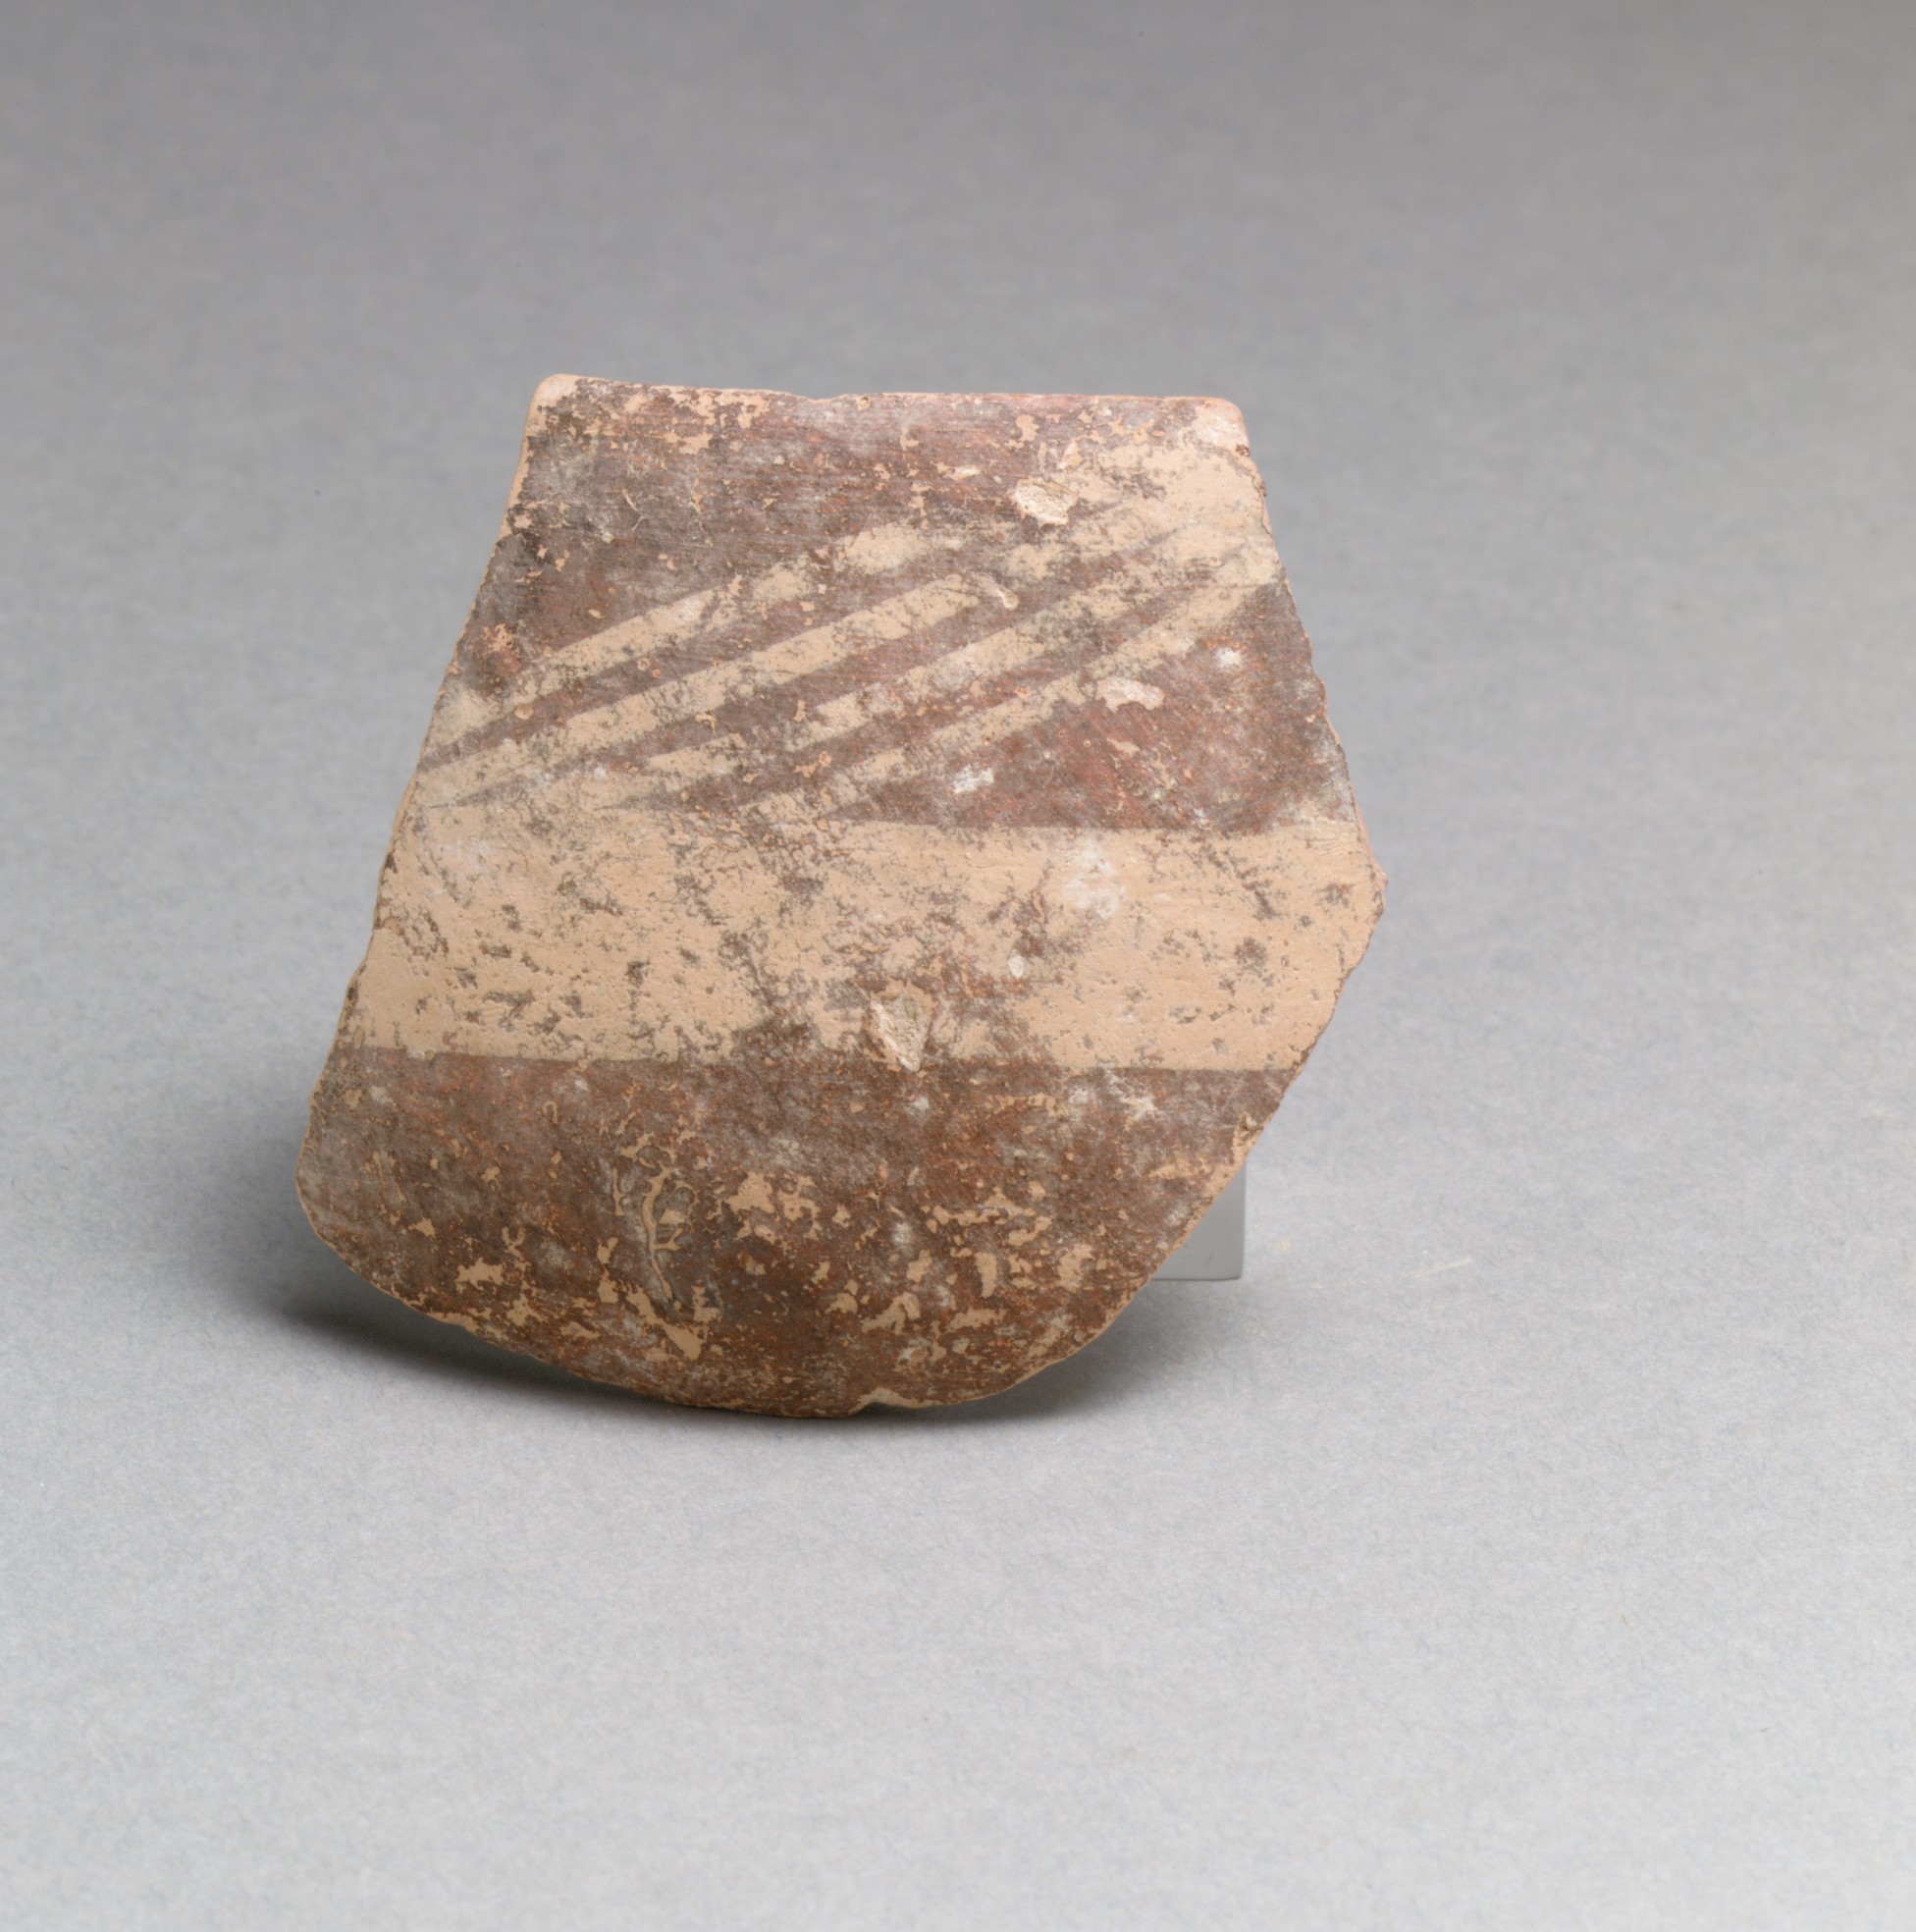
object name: vase fragment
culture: minoan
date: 2600-2000 BCE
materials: terracotta